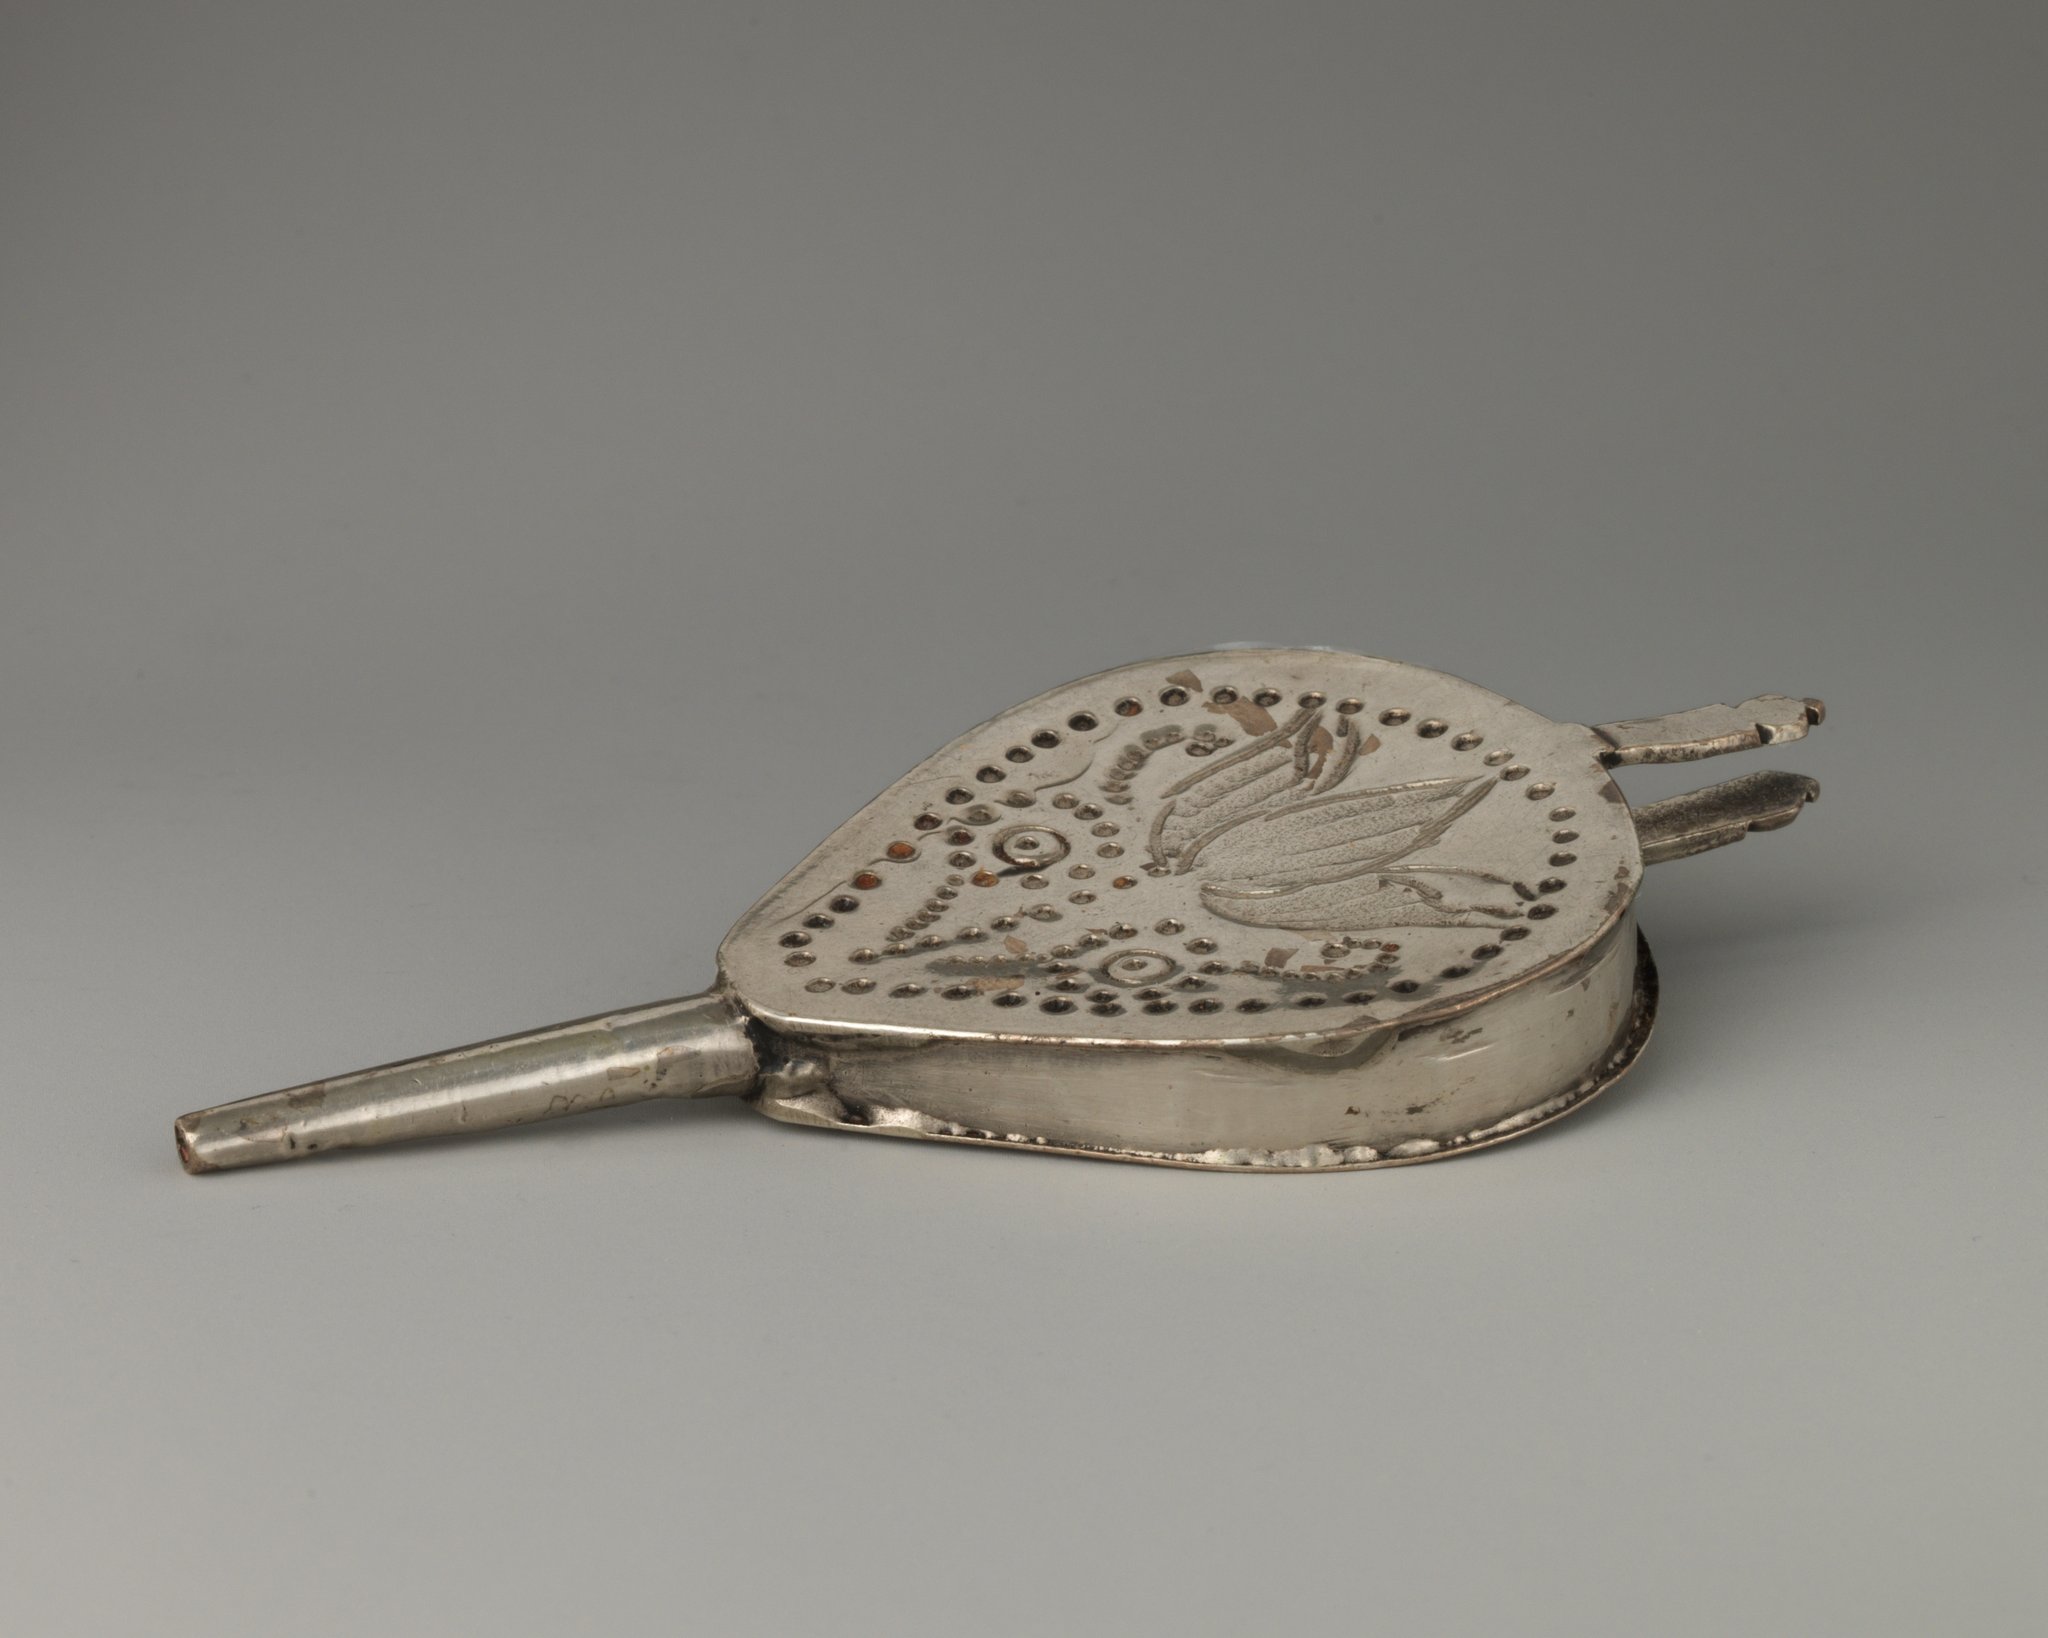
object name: bellow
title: Miniature bellows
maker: george manjoy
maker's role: maker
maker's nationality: british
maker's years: 1685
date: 1690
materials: silver